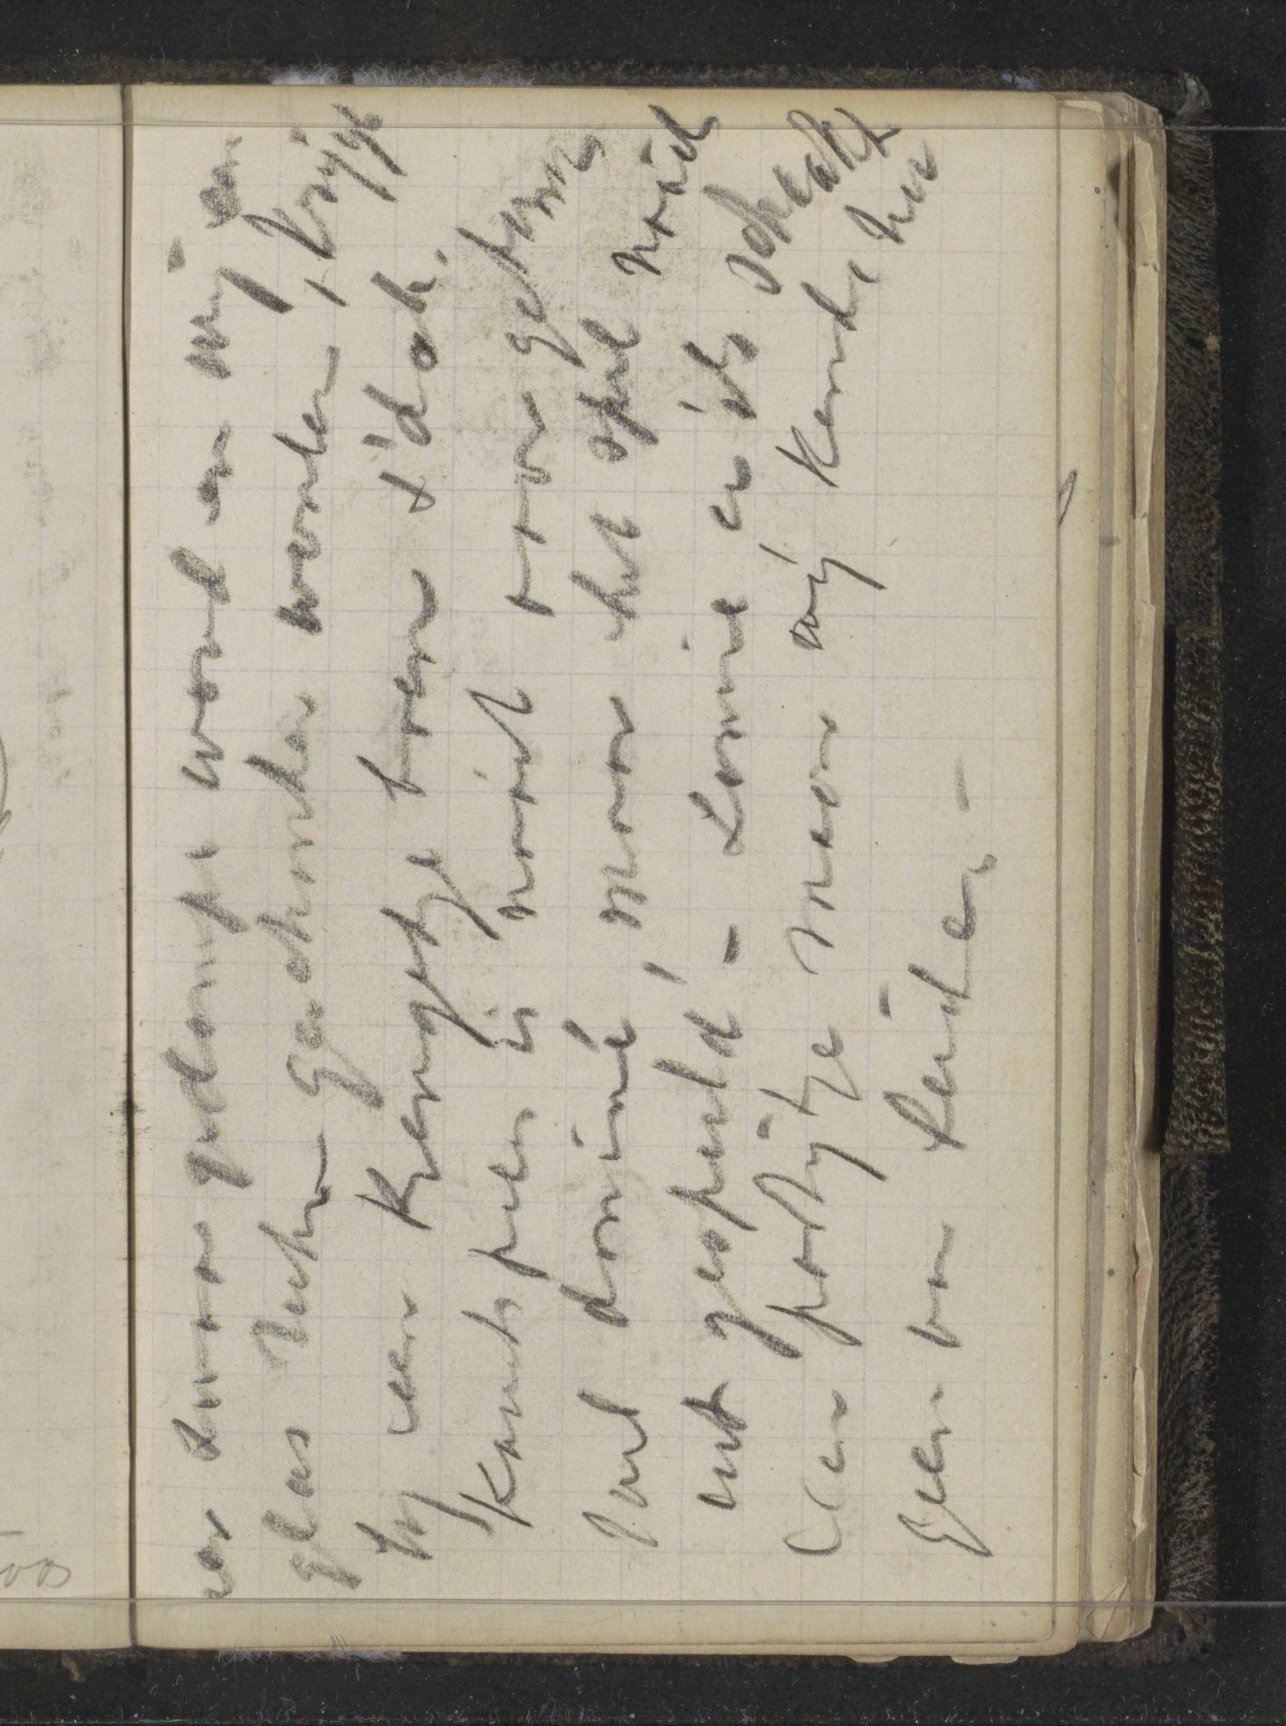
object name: sketchbook leaf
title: Reisverslag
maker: louis apol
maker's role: draughtsman, painter, print maker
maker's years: 1850-1936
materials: chalk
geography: novaya zemlya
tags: nova zembla expedities 1880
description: Blad 79 recto uit een schetsboek met 110 bladen betekend tijdens de expeditie naar Nova Zembla in 1880.